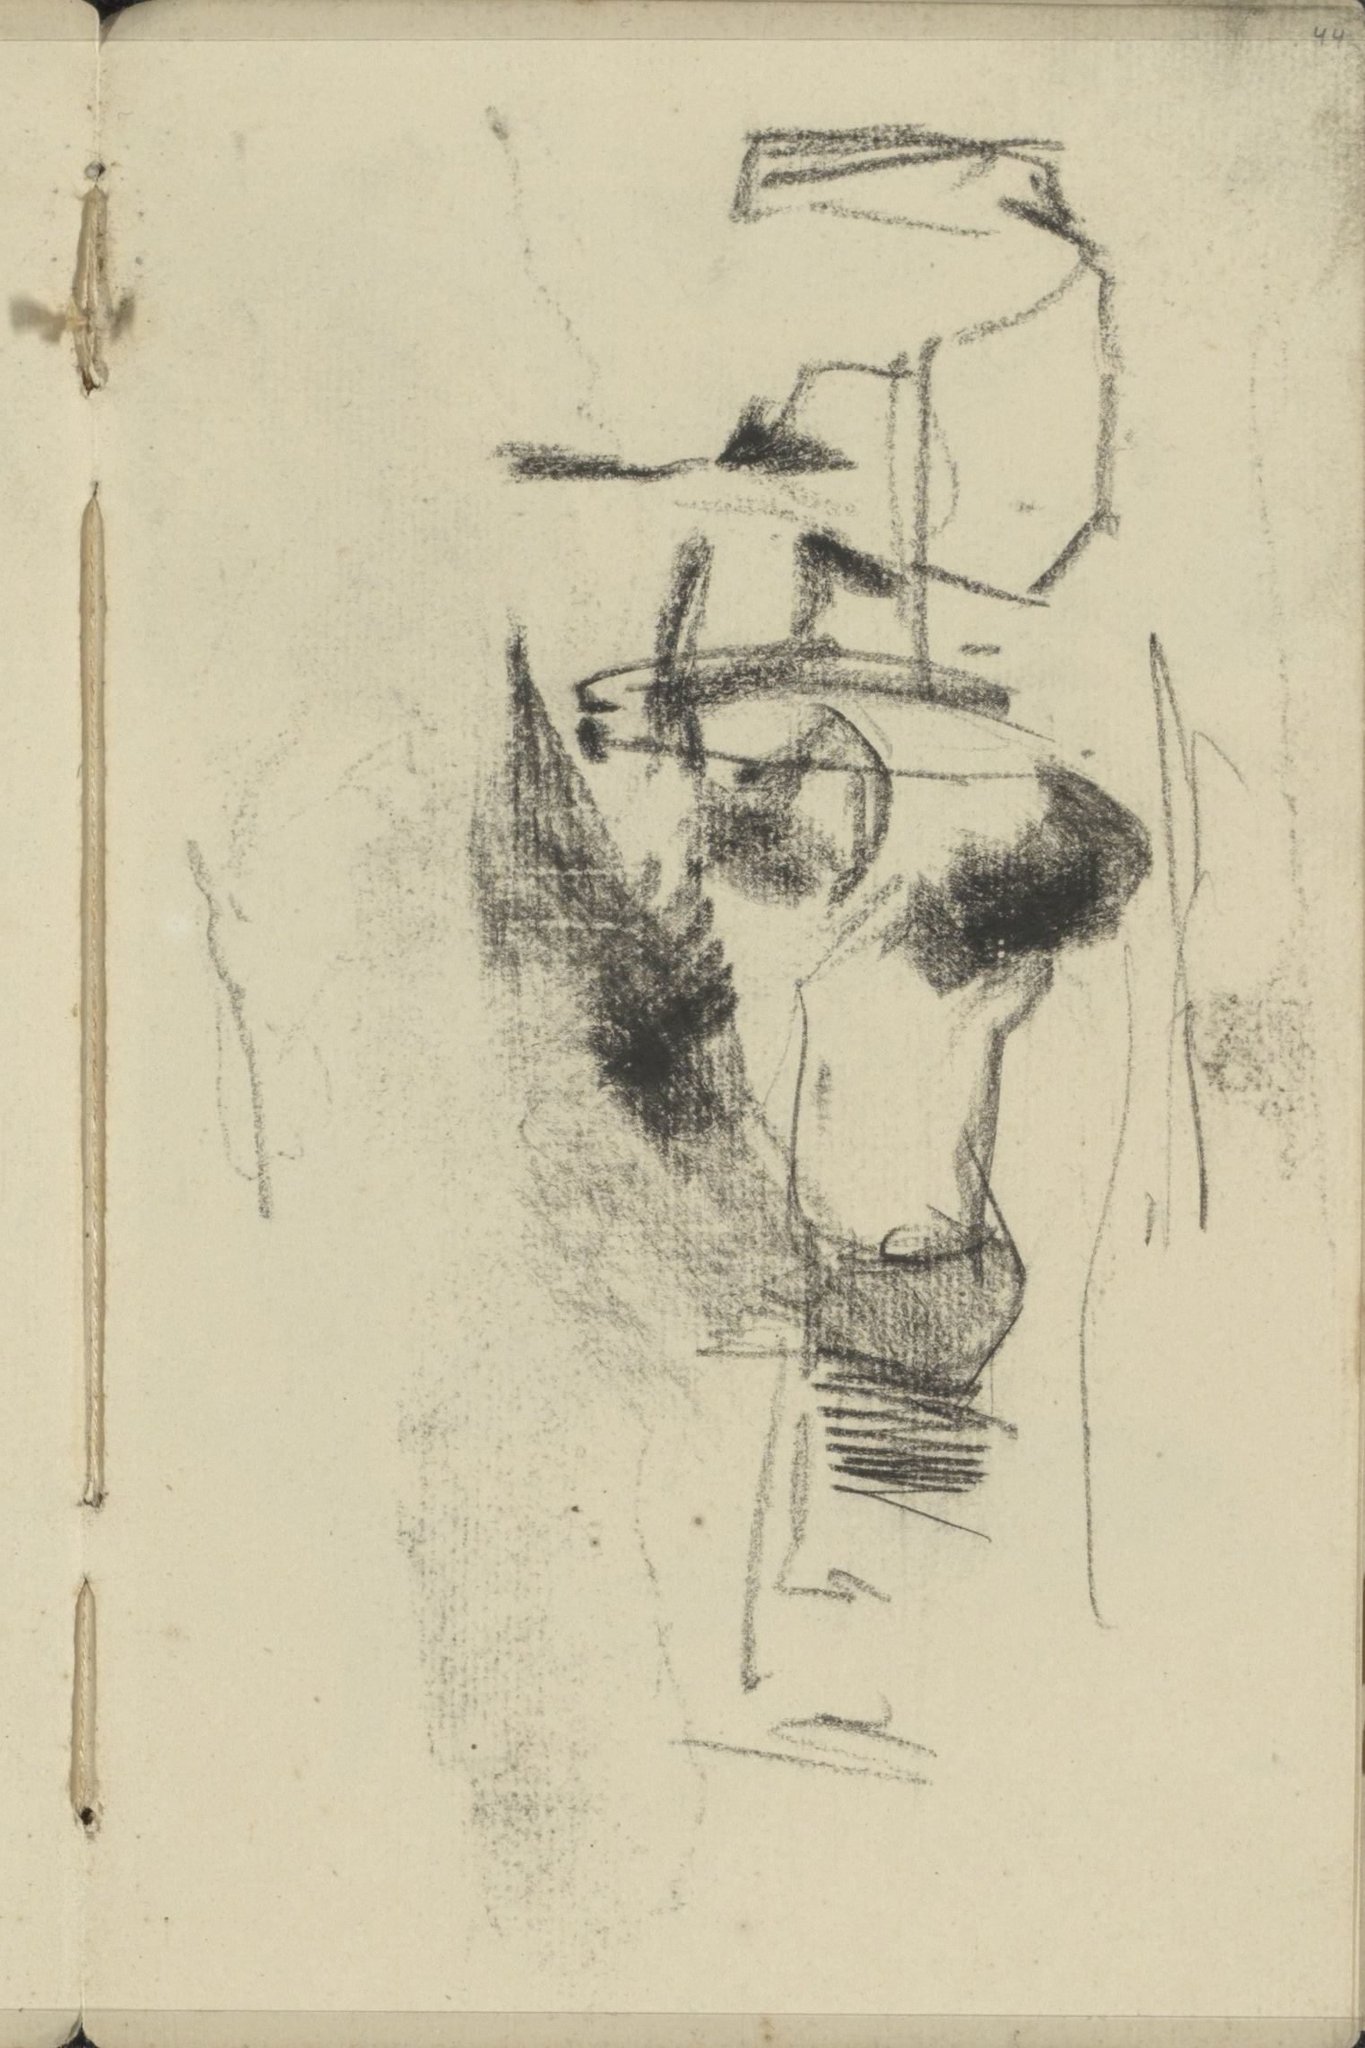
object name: sketchbook leaf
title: Studie, mogelijk van een kar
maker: george hendrik breitner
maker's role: draughtsman, painter, print maker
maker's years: 1857-1923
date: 1882-1884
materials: chalk, paper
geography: the hague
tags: hand-cart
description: Pagina 44 uit een schetsboek met 24 bladen.